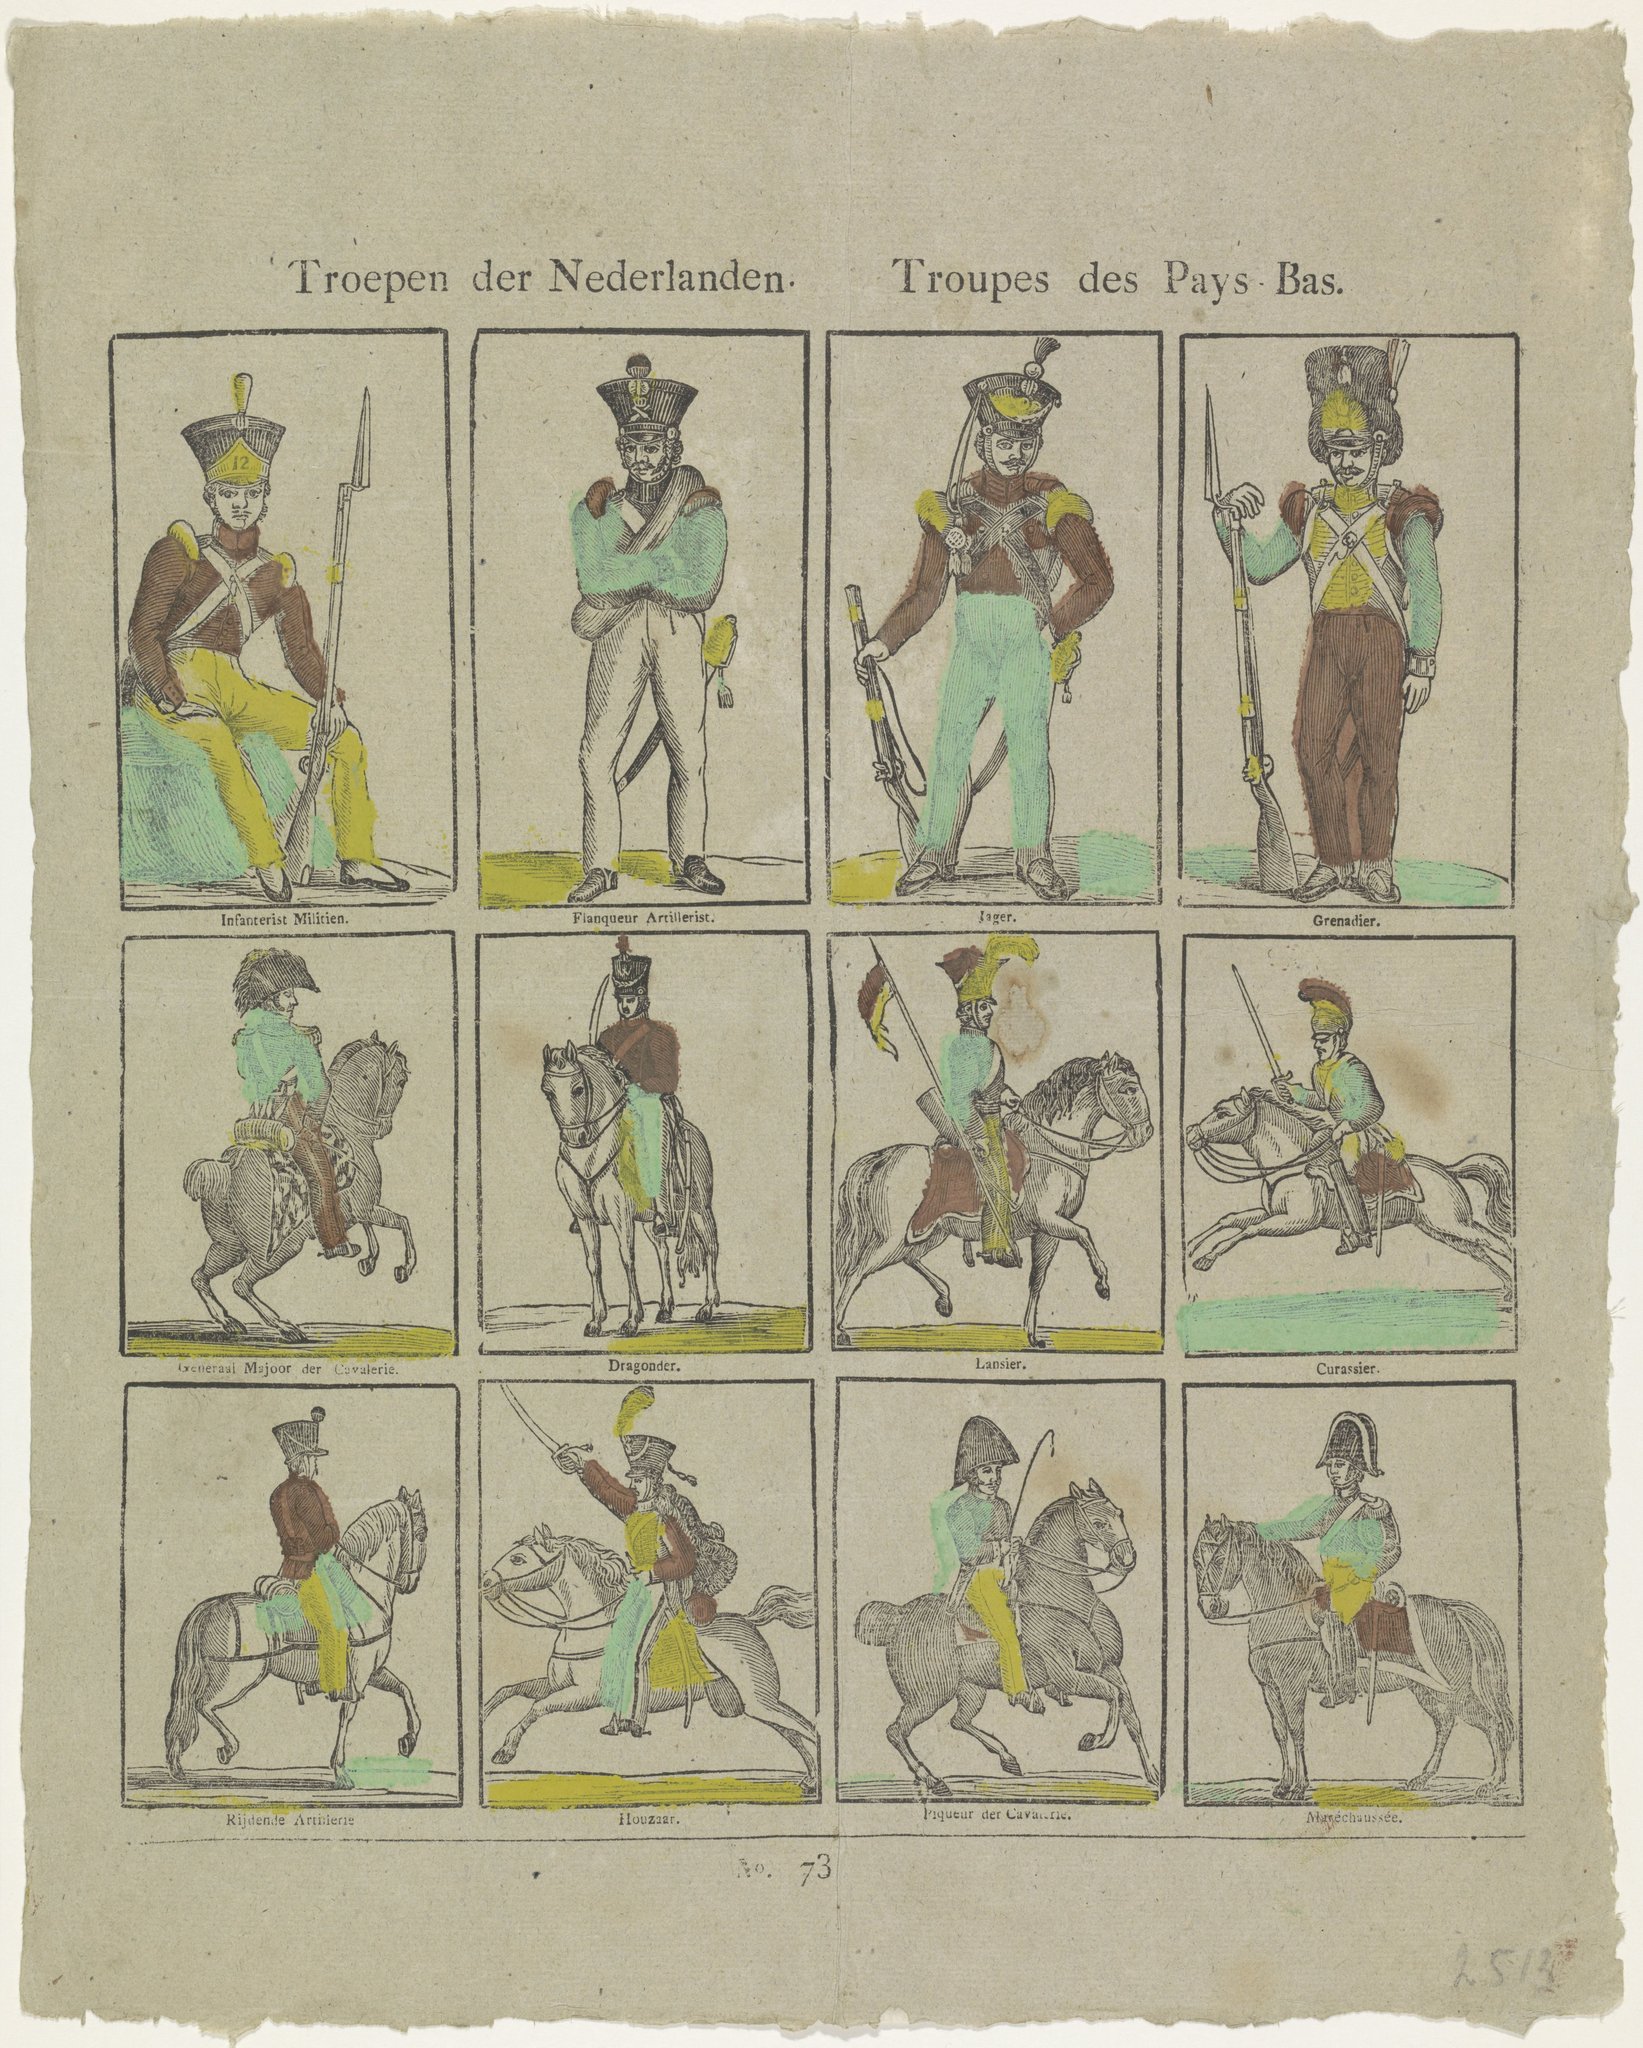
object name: popular print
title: Troepen der Nederlanden / Troupes des Pays-Bas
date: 1800-1833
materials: paper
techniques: colour, letterpress printing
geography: turnhout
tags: the soldier; the soldier's life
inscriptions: collector's mark: Lugt 2228, collector's mark: Lugt 2760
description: Blad met 12 voorstellingen van Nederlandse militairen. Onder elke afbeelding een onderschrift. Genummerd midden onder: No. 73.